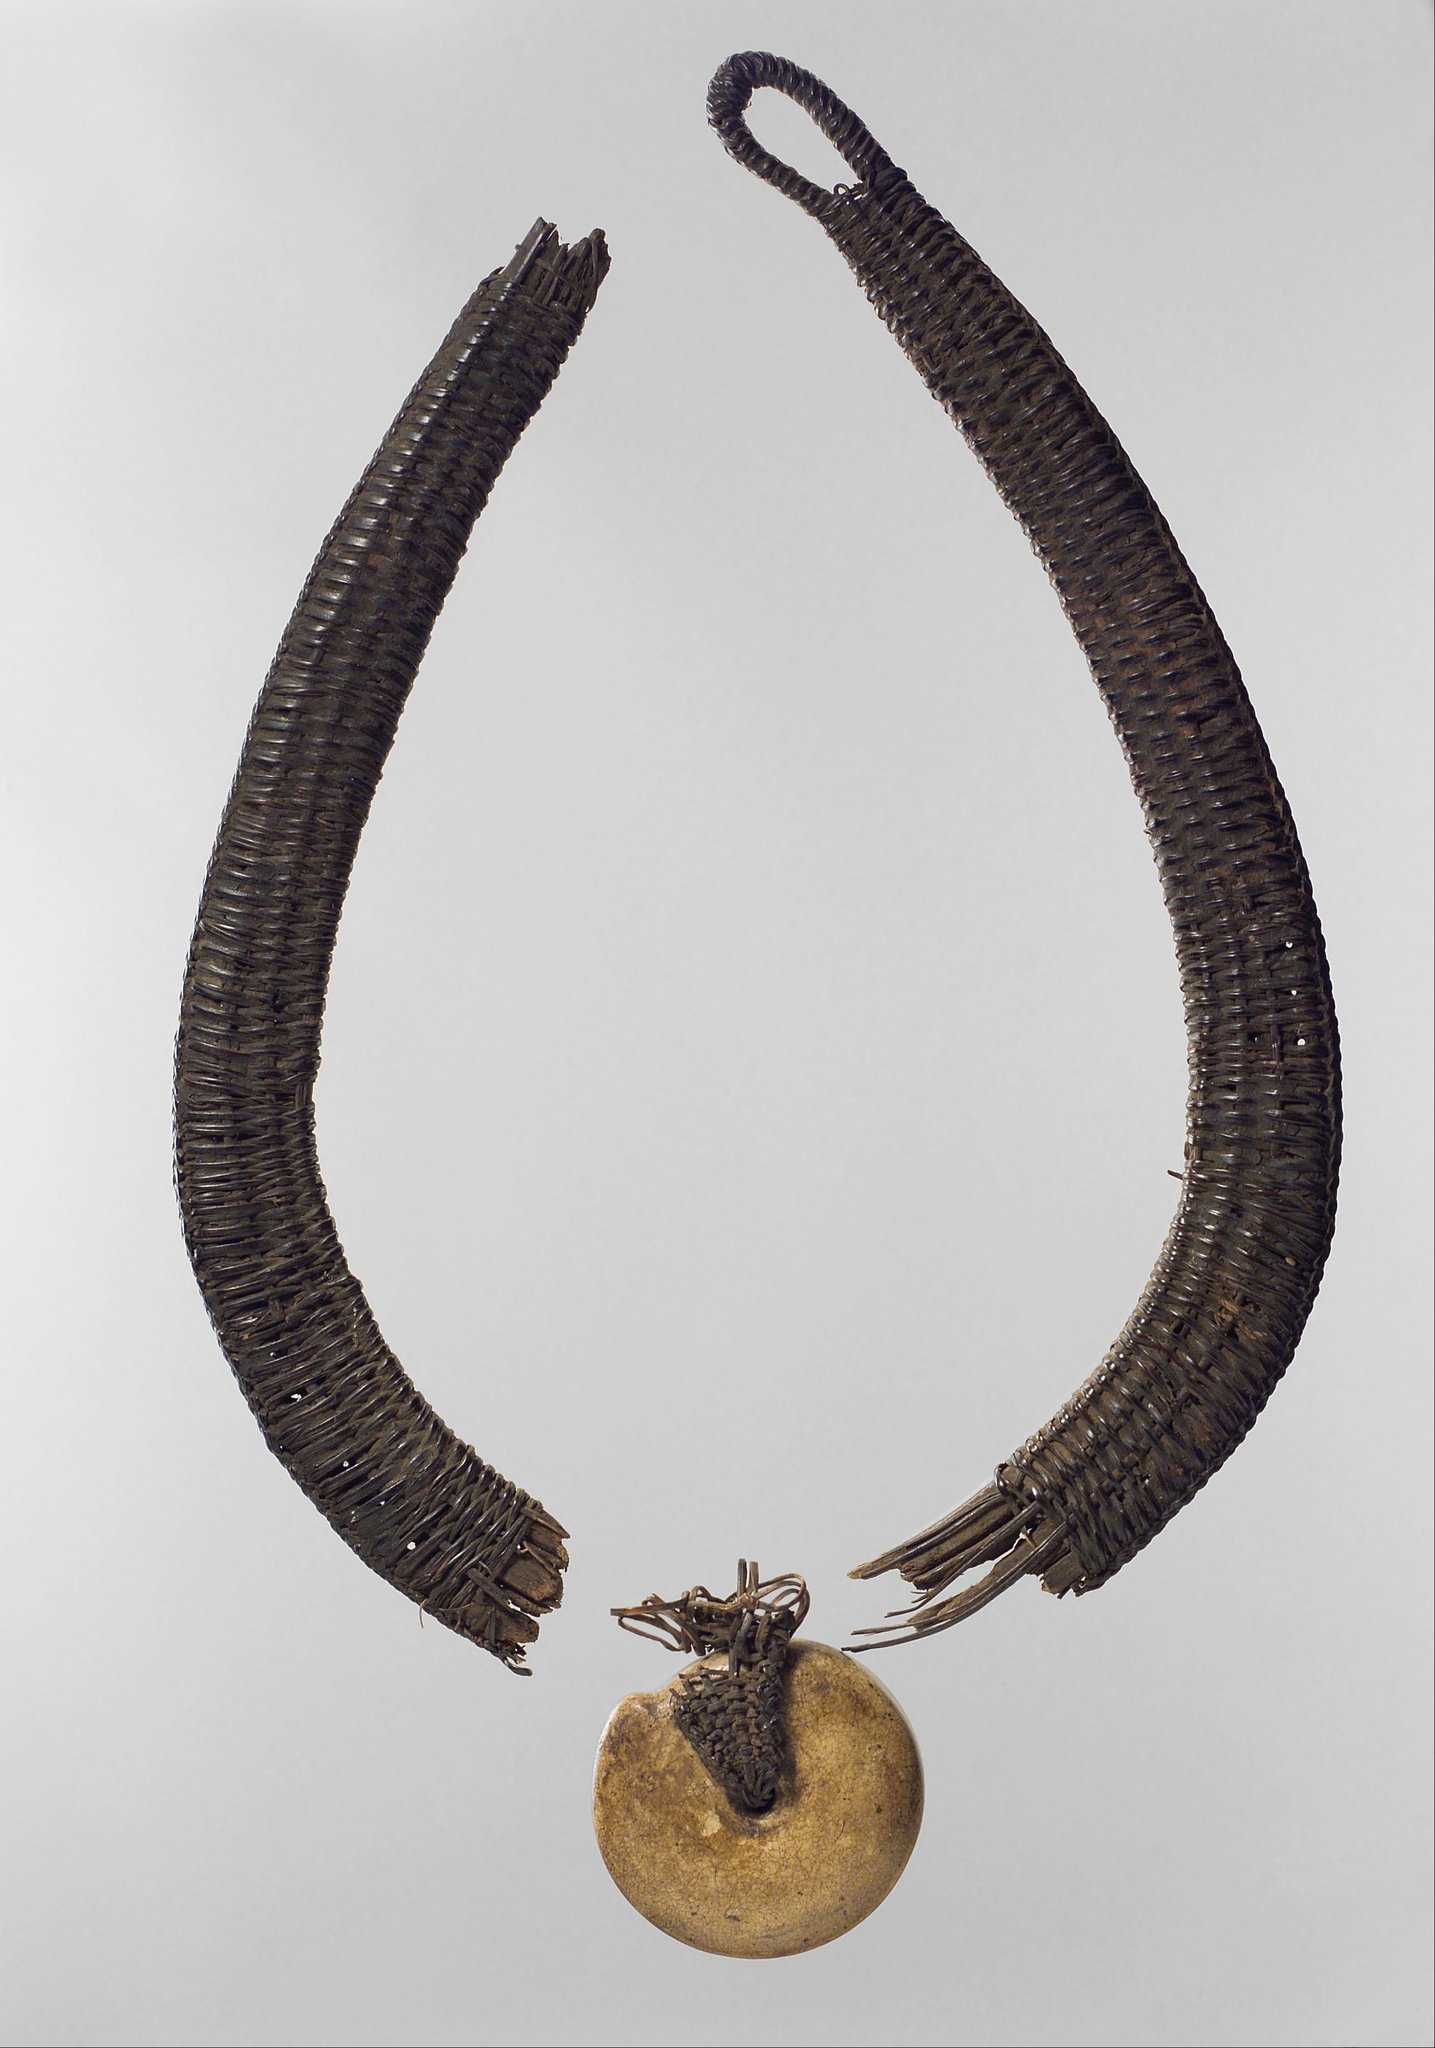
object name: necklace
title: Necklace: Pendant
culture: chokwe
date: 1501-1800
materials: ceramic, raffia, wood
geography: angola